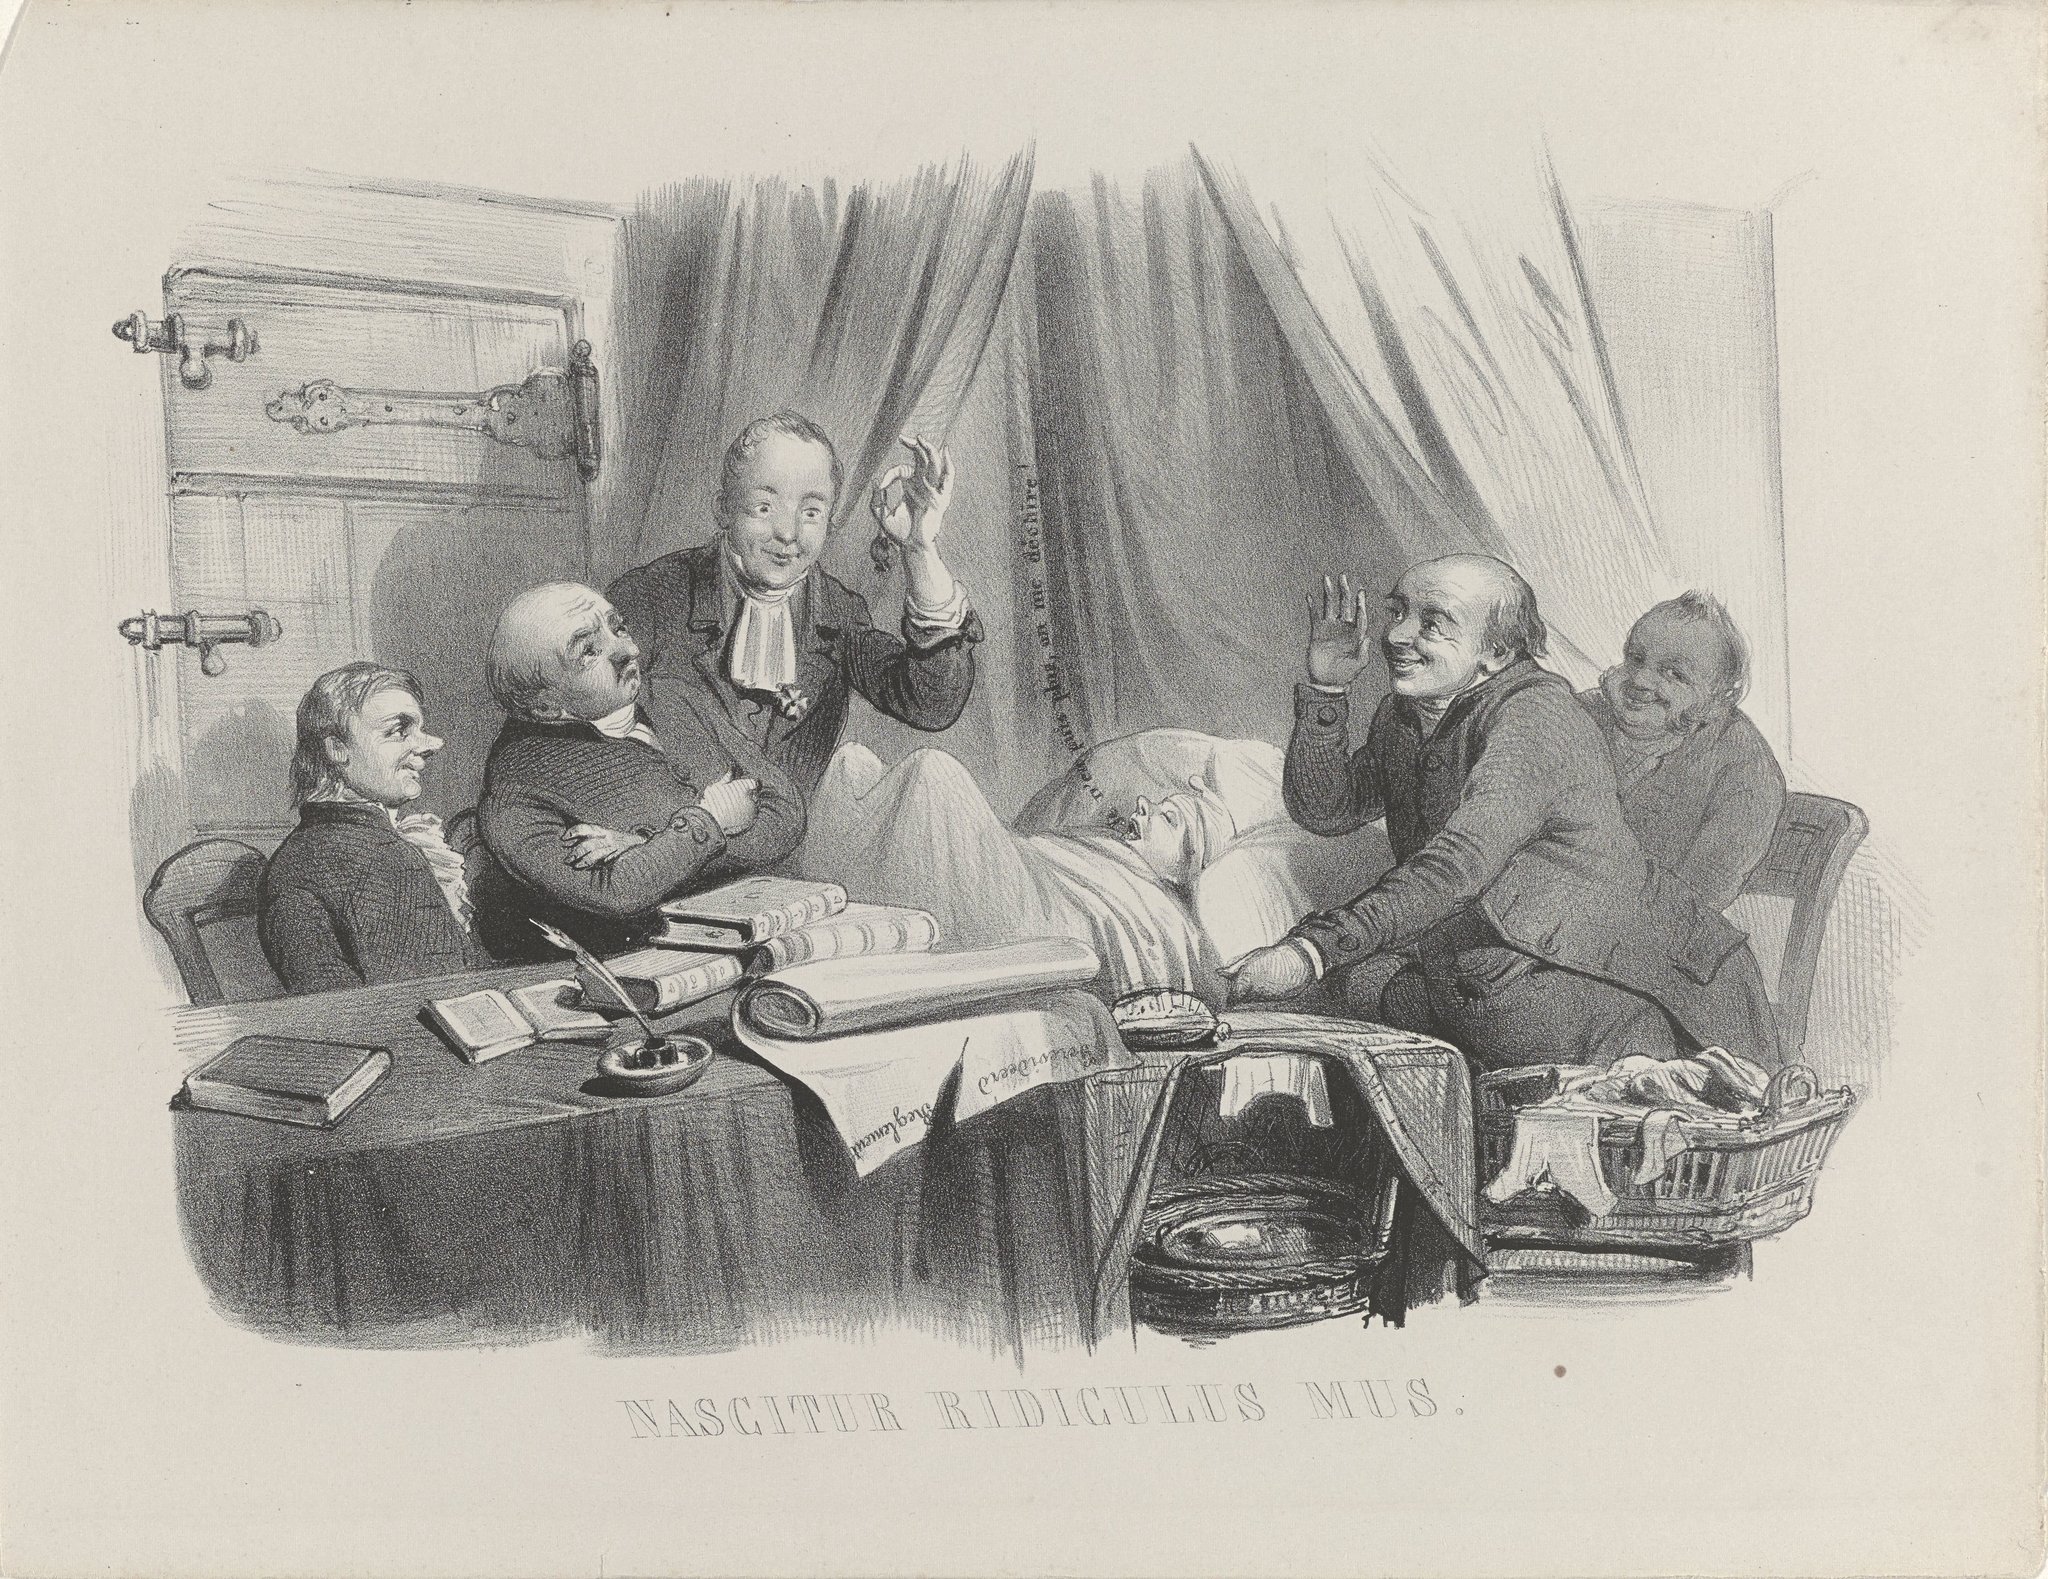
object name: cartoon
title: Nascitur Ridiculus Mus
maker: Anonymous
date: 1849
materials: paper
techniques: lithograph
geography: zaltbommel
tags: organizations, assemblies, etc. in protestant churches, lying-in room, amsterdam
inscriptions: collector's mark: Lugt 2228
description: Spotprent op de totstandkoming van het concept-reglement. De commissieleden bijeen rondom een tafel naast een kraambed waarin iemand met opgetrokken benen ligt te slapen. Losse prent in de omslag met twee andere spotprenten en een tekstblad over de vergadering van de Algemene Synode van de Hervormde Kerk te Amsterdam op 4 juli 1849.